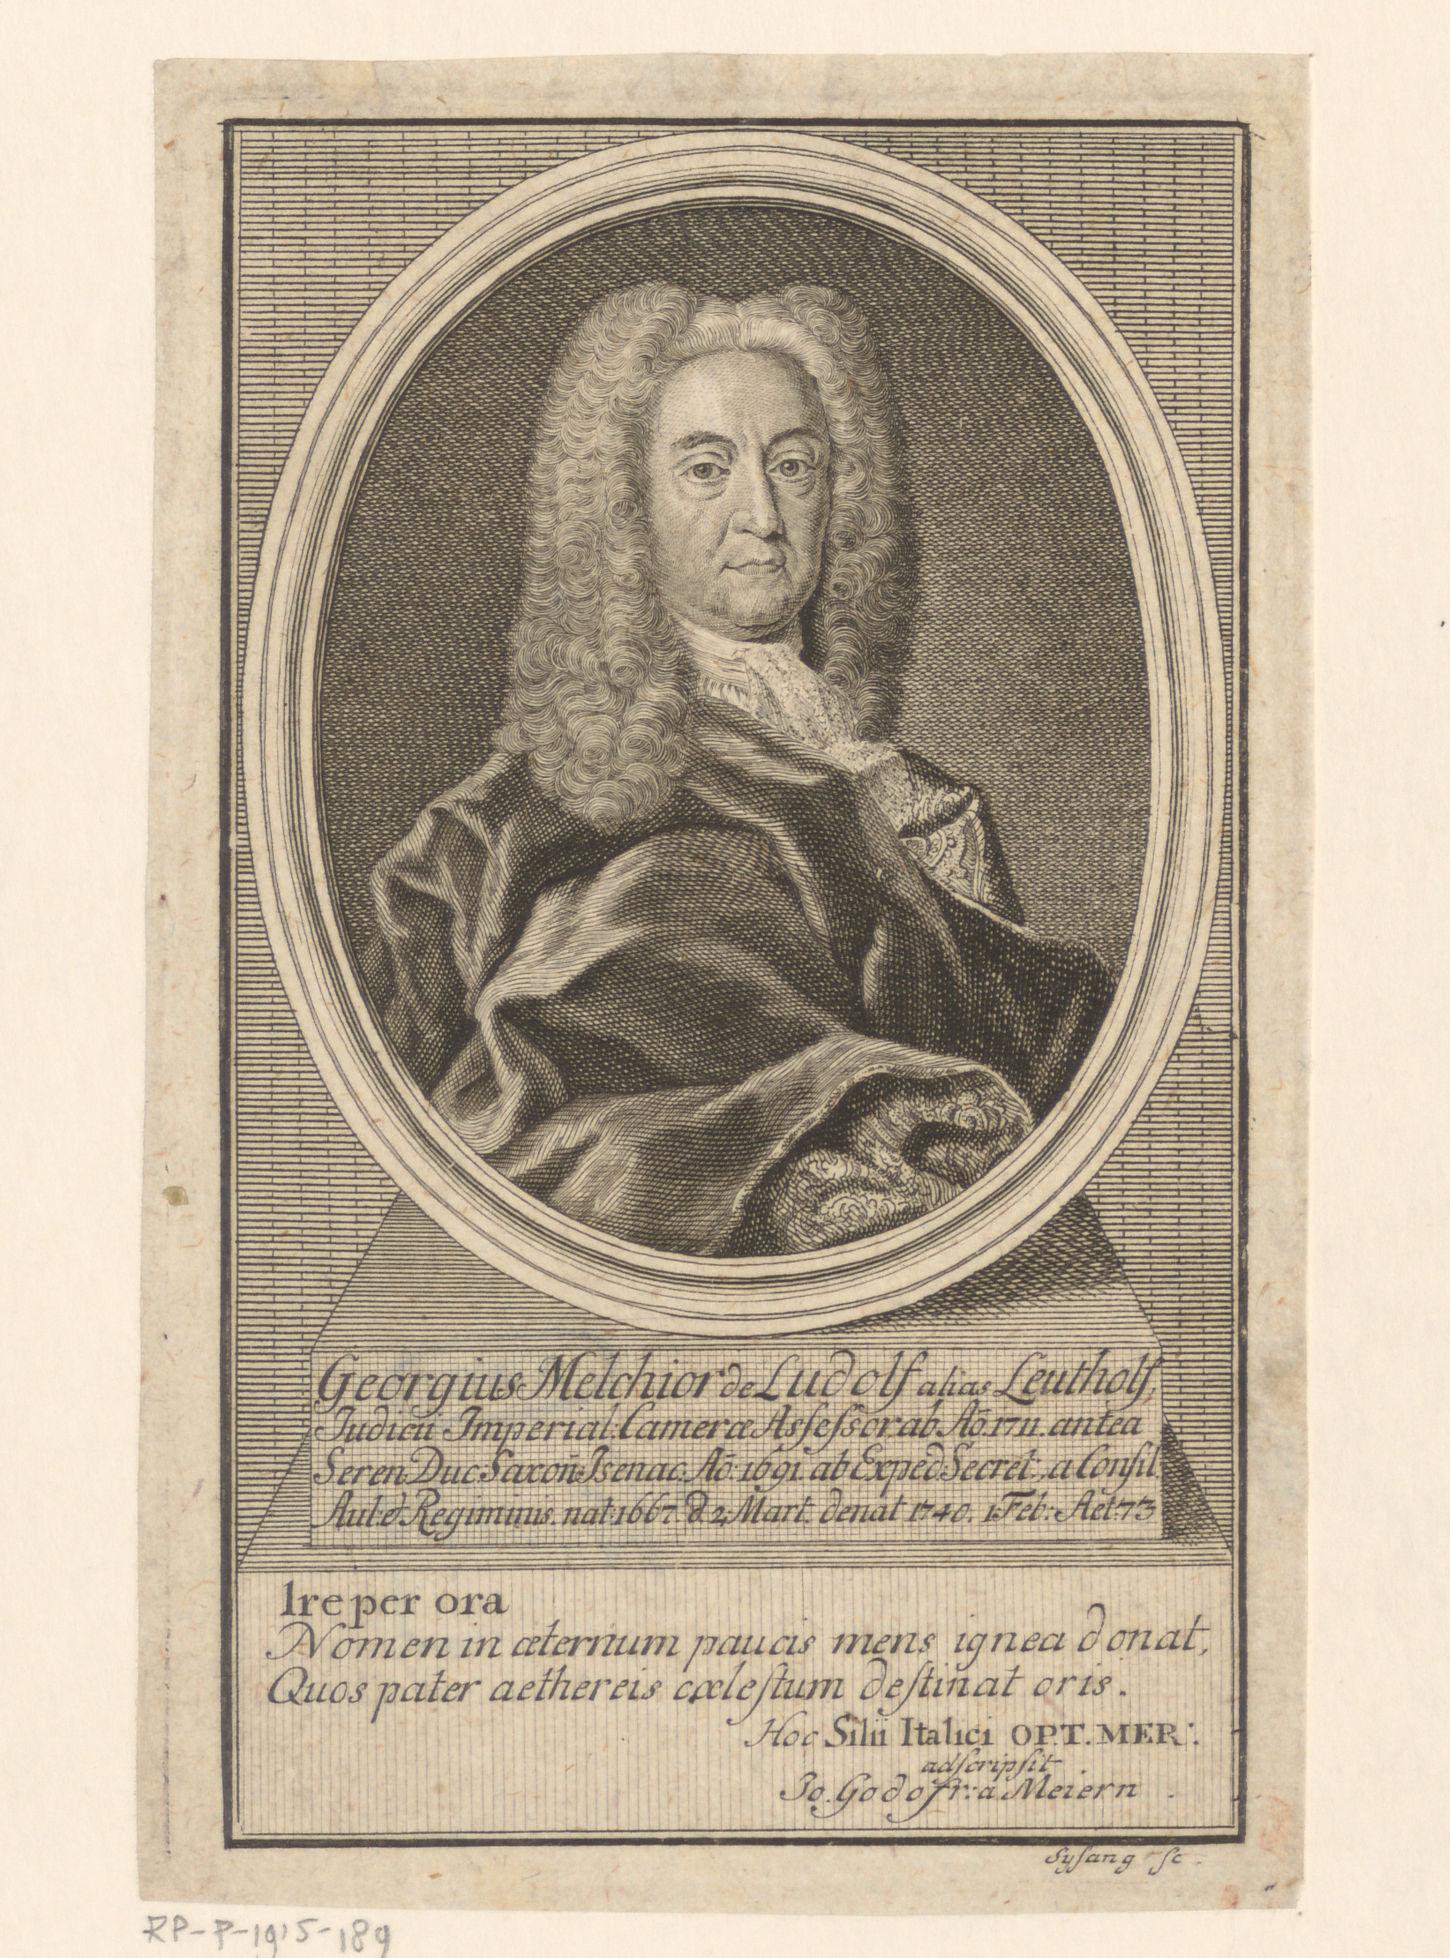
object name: print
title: Portret van Georg Melchior von Ludolf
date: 1713-1757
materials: paper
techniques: engraving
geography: germany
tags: historical persons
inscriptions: collector's mark: Lugt 2228